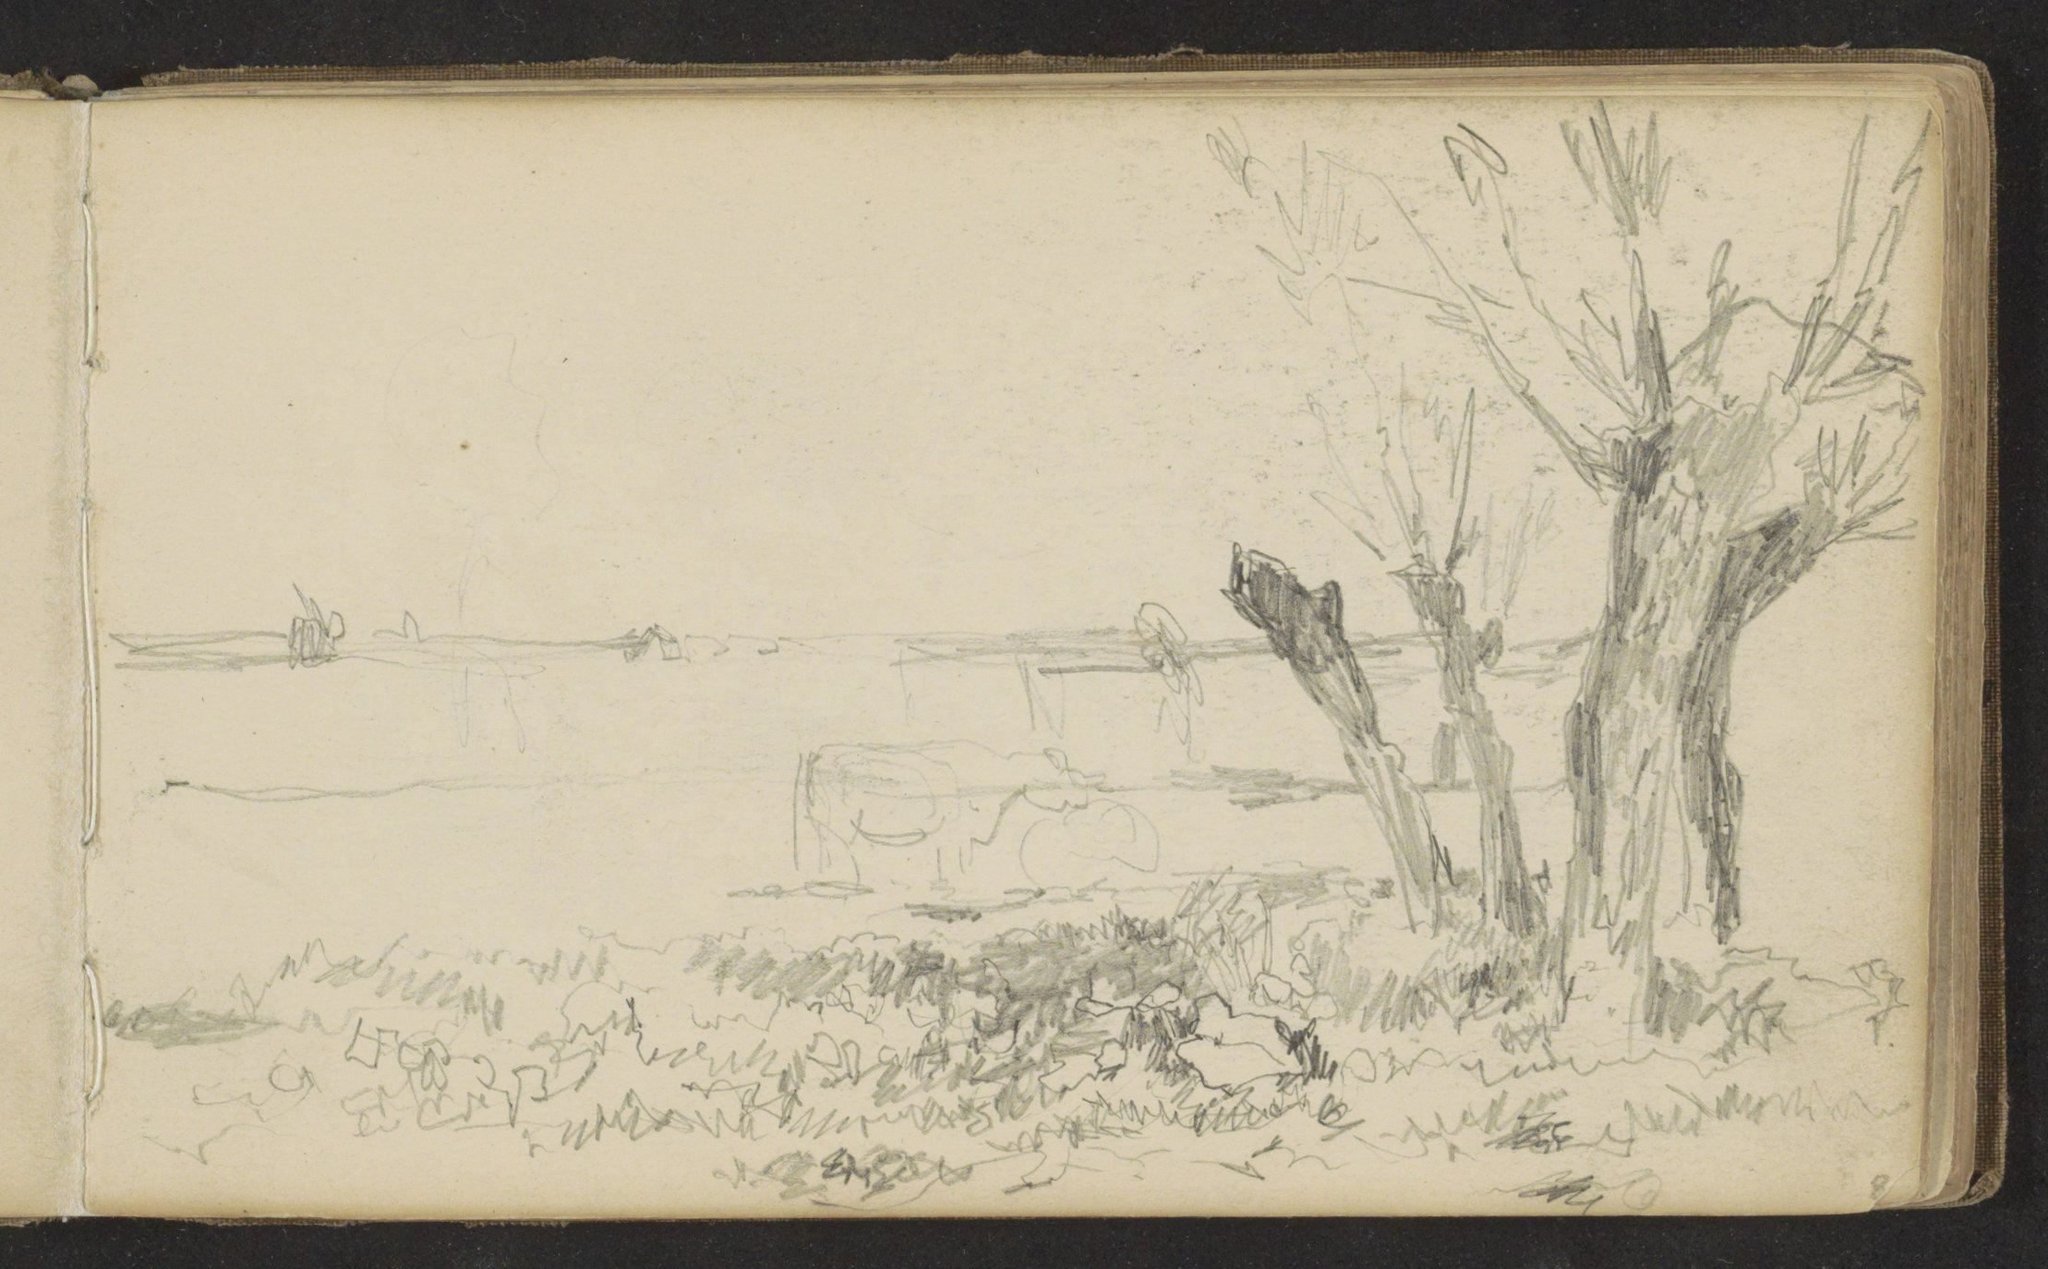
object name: sketchbook leaf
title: Koe in een weiland met knotwilgen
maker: johan hendrik weissenbruch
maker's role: draughtsman, painter, print maker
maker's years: 1824-1903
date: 1834-1903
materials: paper, pencil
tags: cow, meadow, pasture, trees: willow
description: Blad 8 recto uit een schetsboek met 43 bladen.